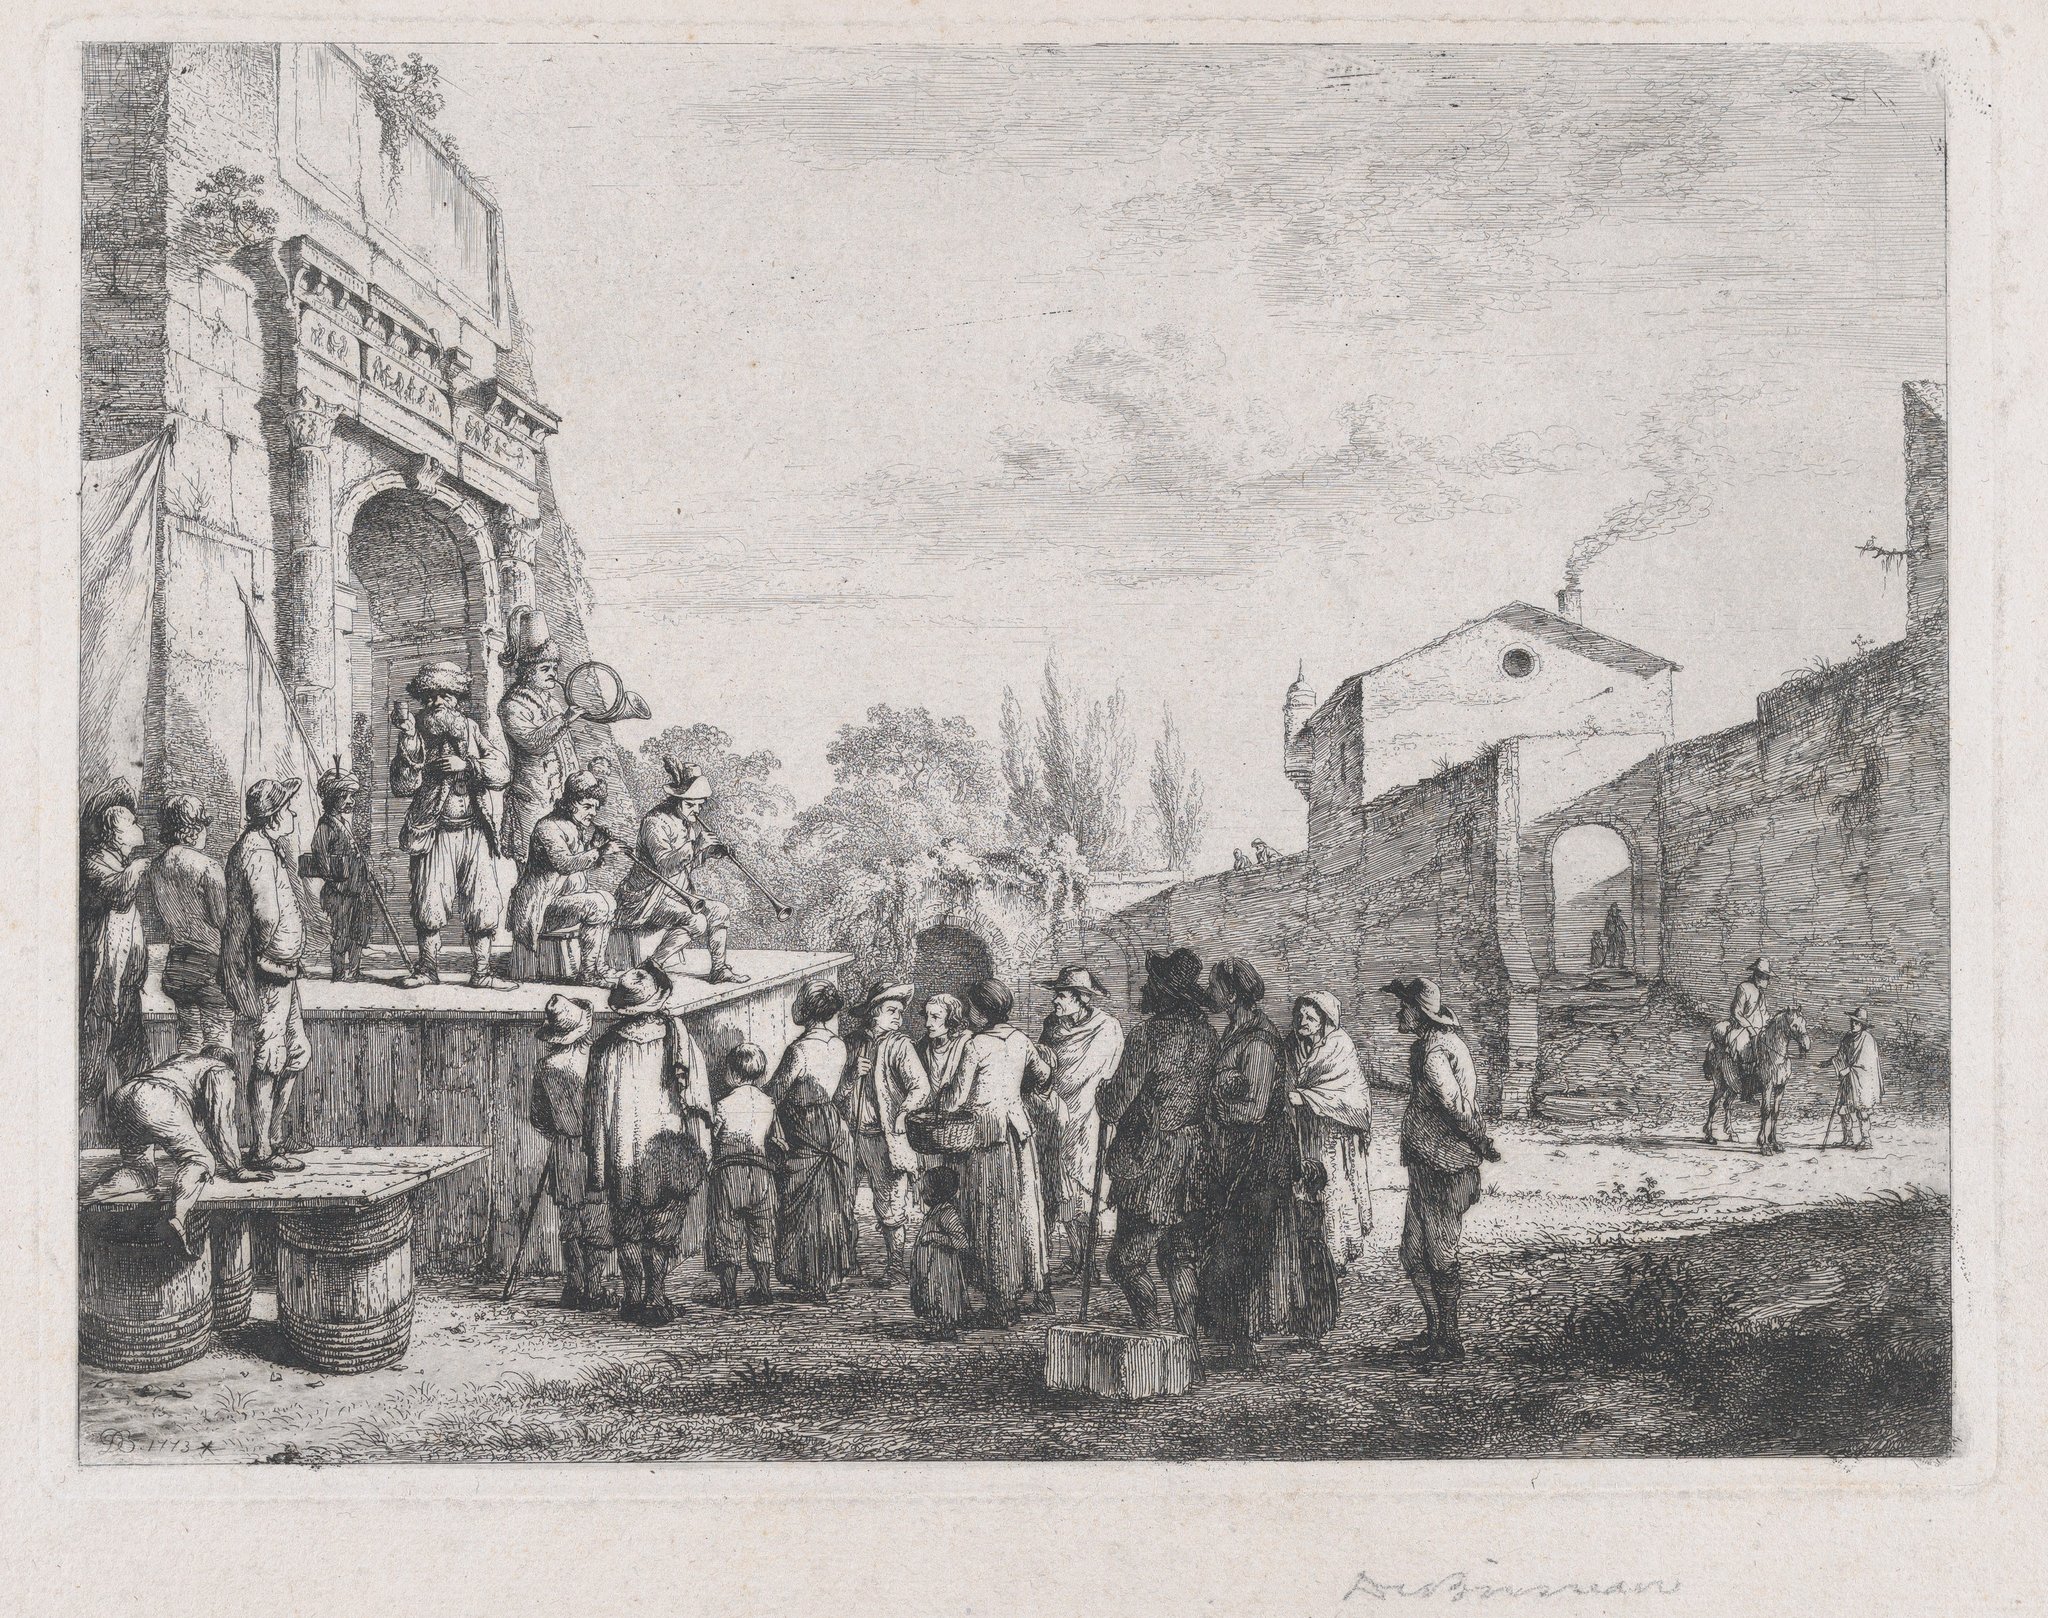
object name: print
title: The Little Charlatans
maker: jean jacques de boissieu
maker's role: artist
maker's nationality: french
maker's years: 1736-1810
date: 1773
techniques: etching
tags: musical instruments,boys,men,women,music